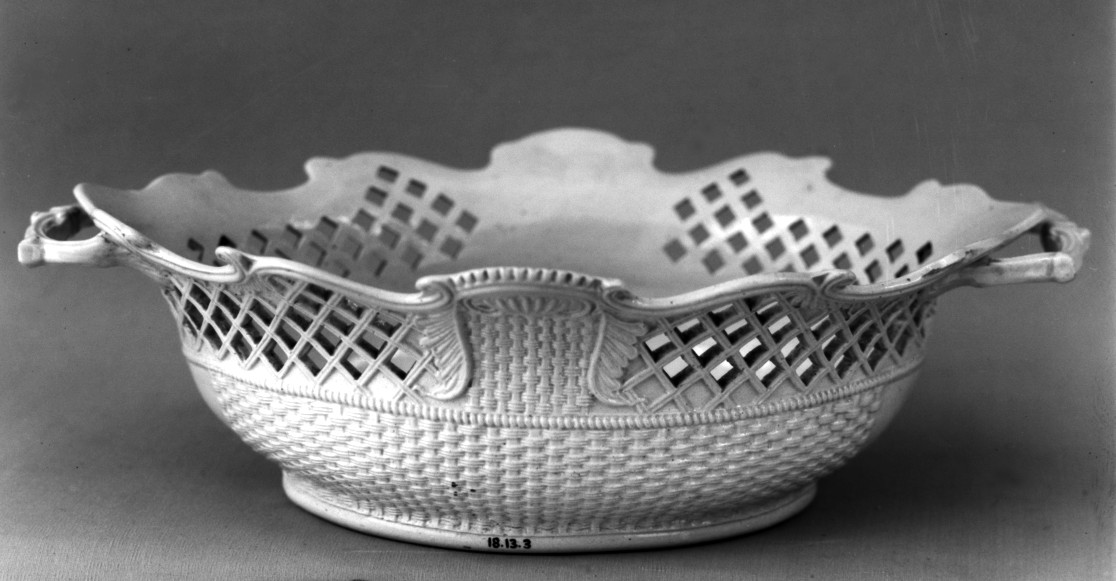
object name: fruit basket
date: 1760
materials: stoneware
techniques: salt glaze